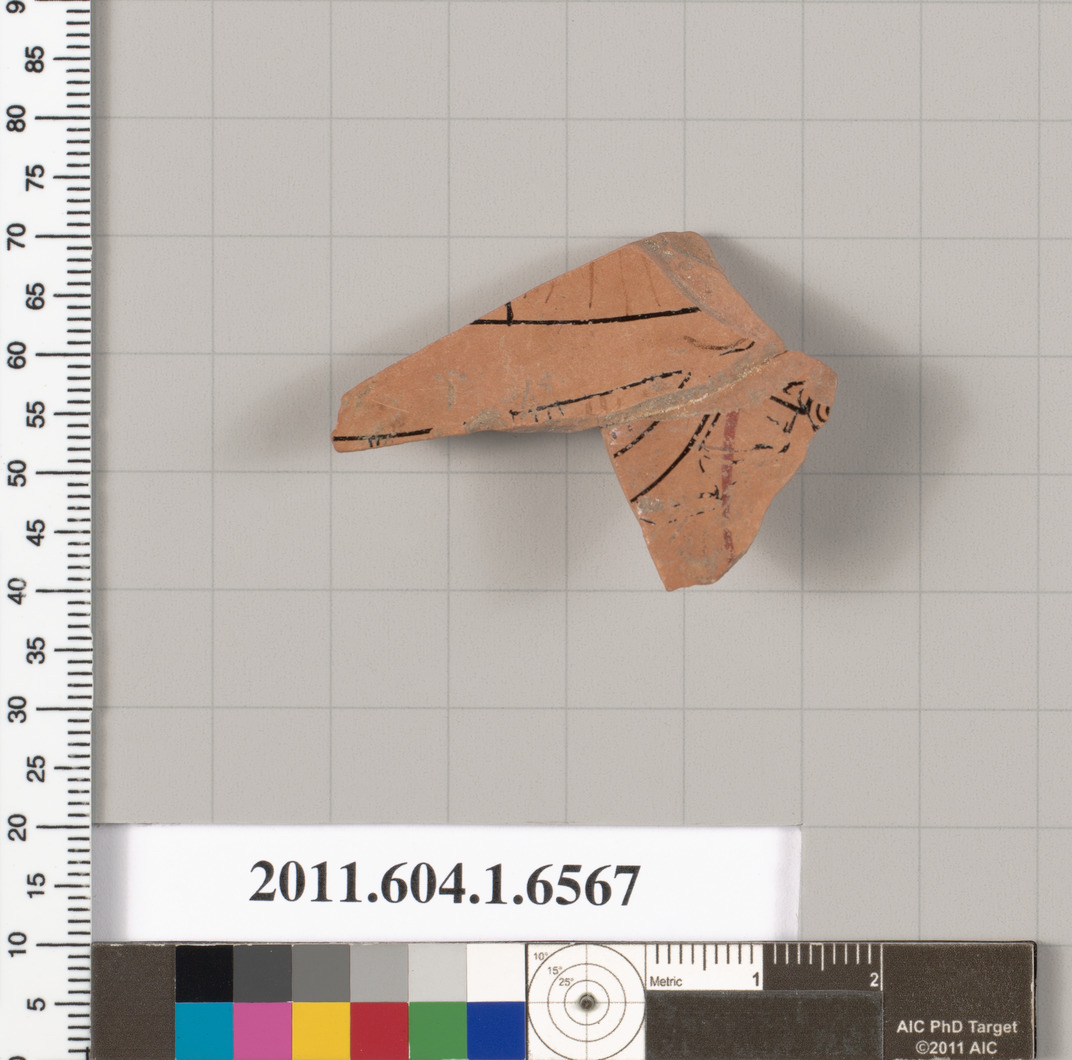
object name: kylix fragment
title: Terracotta fragment of a kylix (drinking cup)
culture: greek, attic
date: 490-480 BCE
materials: terracotta